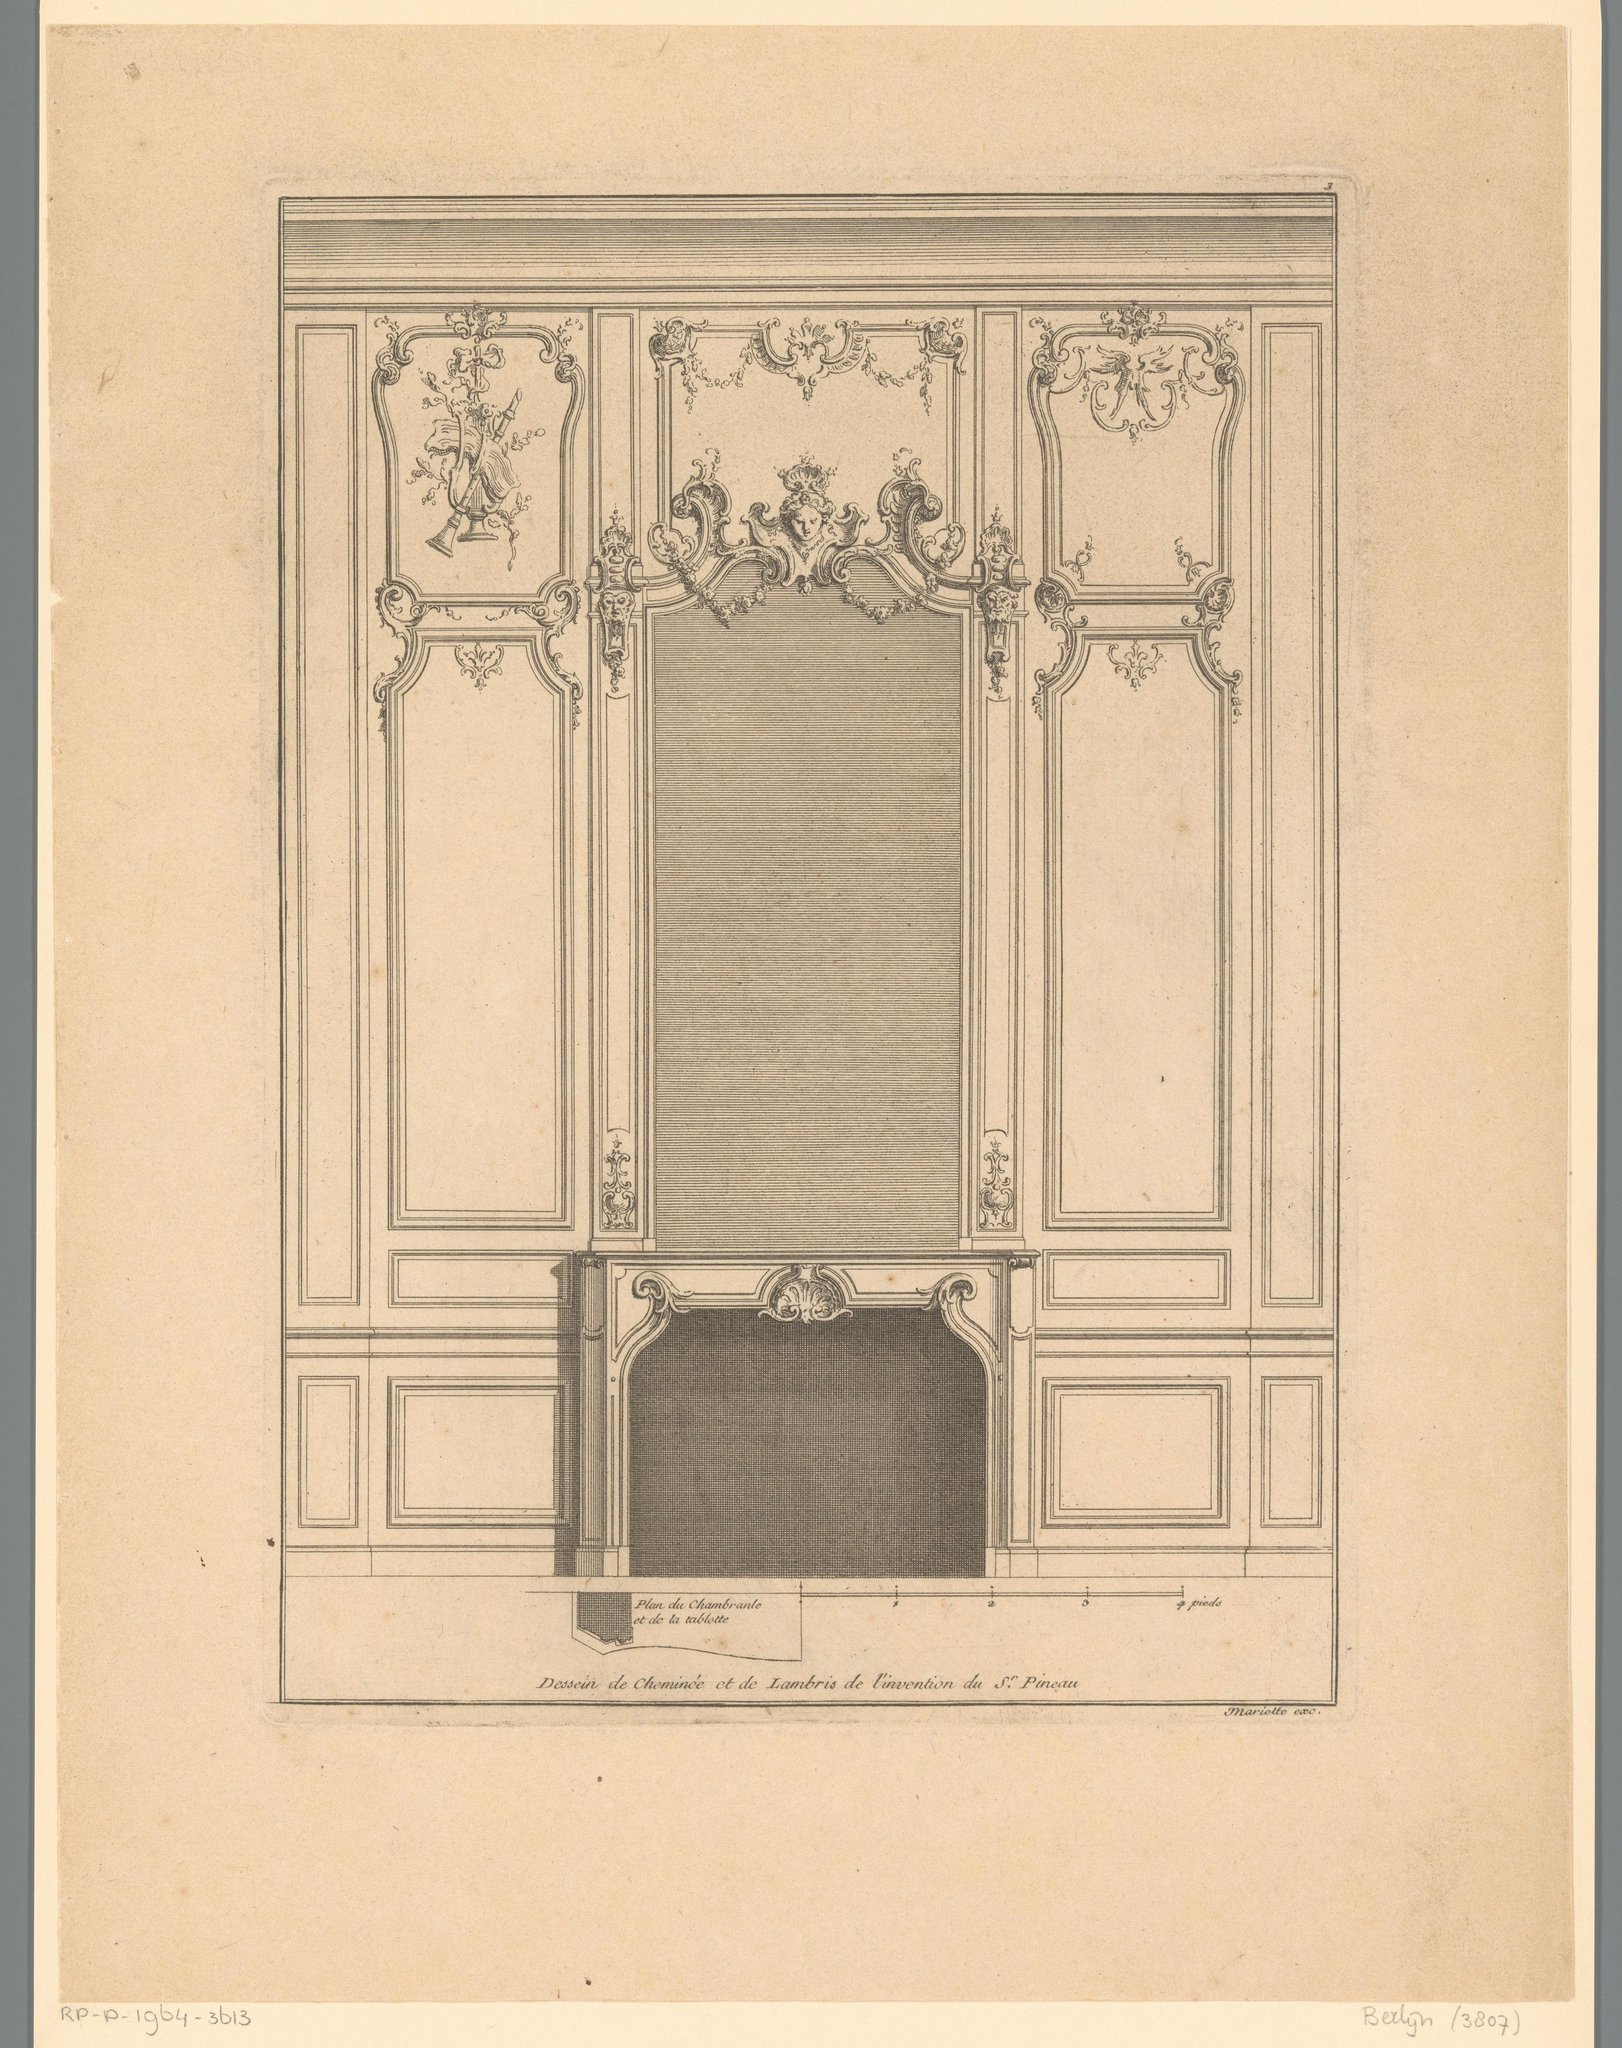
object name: ornament print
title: Schouwen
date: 1694-1742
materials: paper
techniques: engraving, etching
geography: paris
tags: rocaille ornament, lyre, cithara, psaltery, open hearth, fire-place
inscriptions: collector's mark: Lugt 2760, collector's mark: Lugt 2228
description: Een geornamenteerde schouw met rocaille ornamenten en aan de bovenzijde een masker en guirlandes. Links boven een paneel met een lier, fluit en bladmuziek.